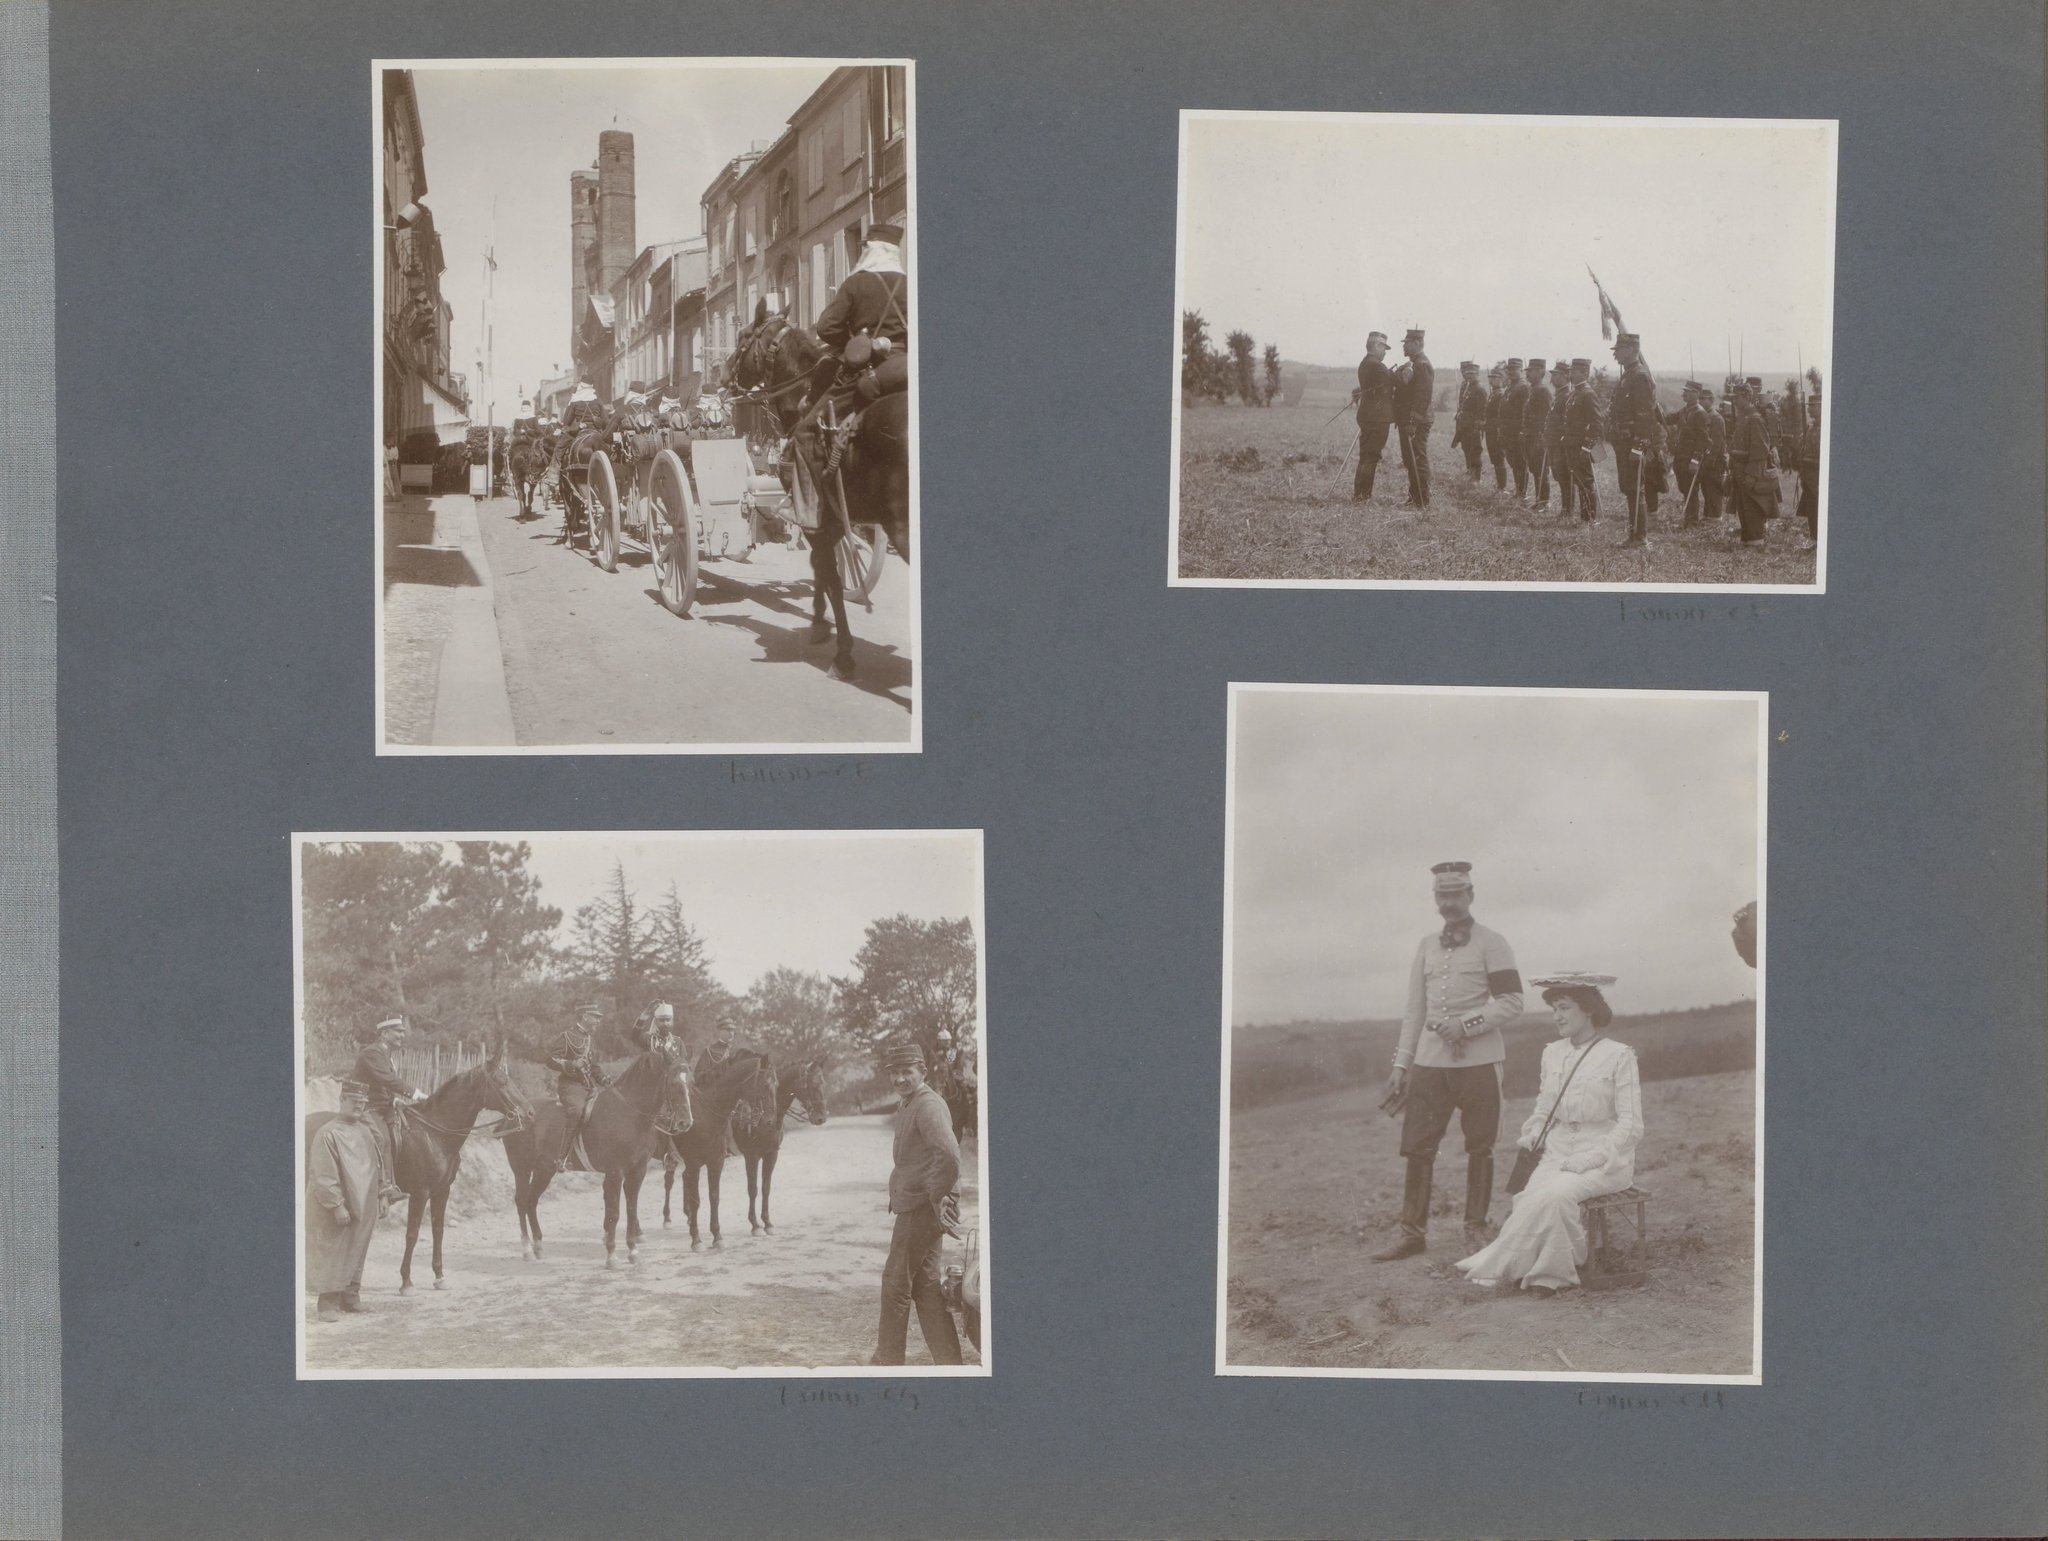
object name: photograph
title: Intocht van militairen, mogelijk in Toulouse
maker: Anonymous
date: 1902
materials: paper, photographic support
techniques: daylight paper print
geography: france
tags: marching away (troops), four-wheeled, animal-drawn vehicle, e.g.: cab, carriage, coach, land forces, france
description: Onderdeel van Fotoalbum van een legeroefening in Zuidwest-Frankrijk in 1902.